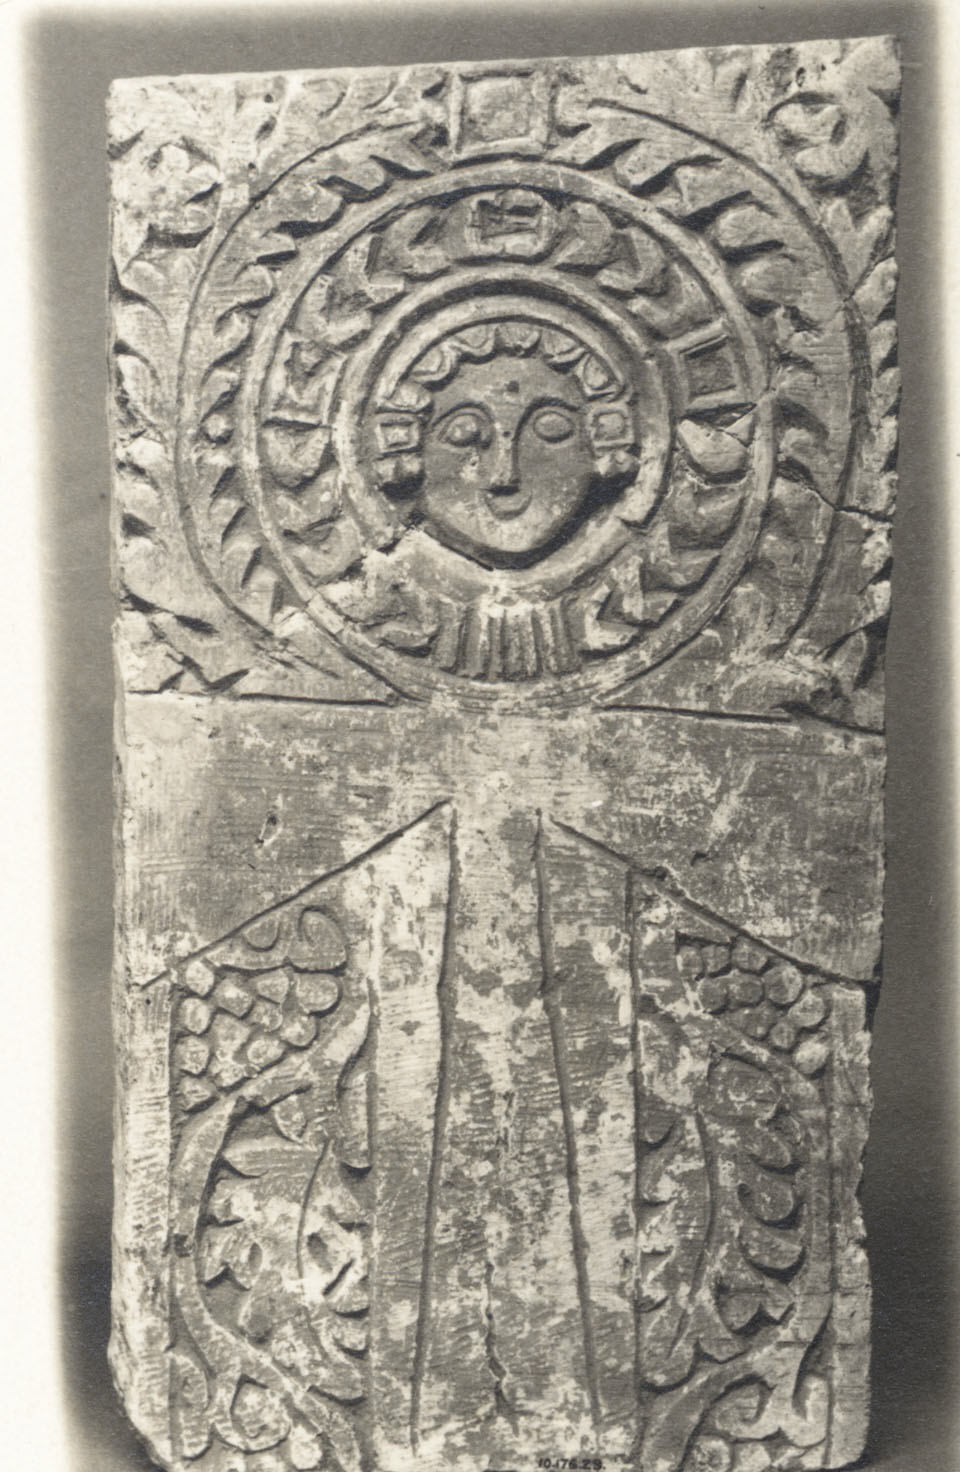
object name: stele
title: Funerary Stele with Ankh (Looped Cross) Featuring a Human Face at the Center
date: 501-700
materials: limestone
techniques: carving, relief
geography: egypt